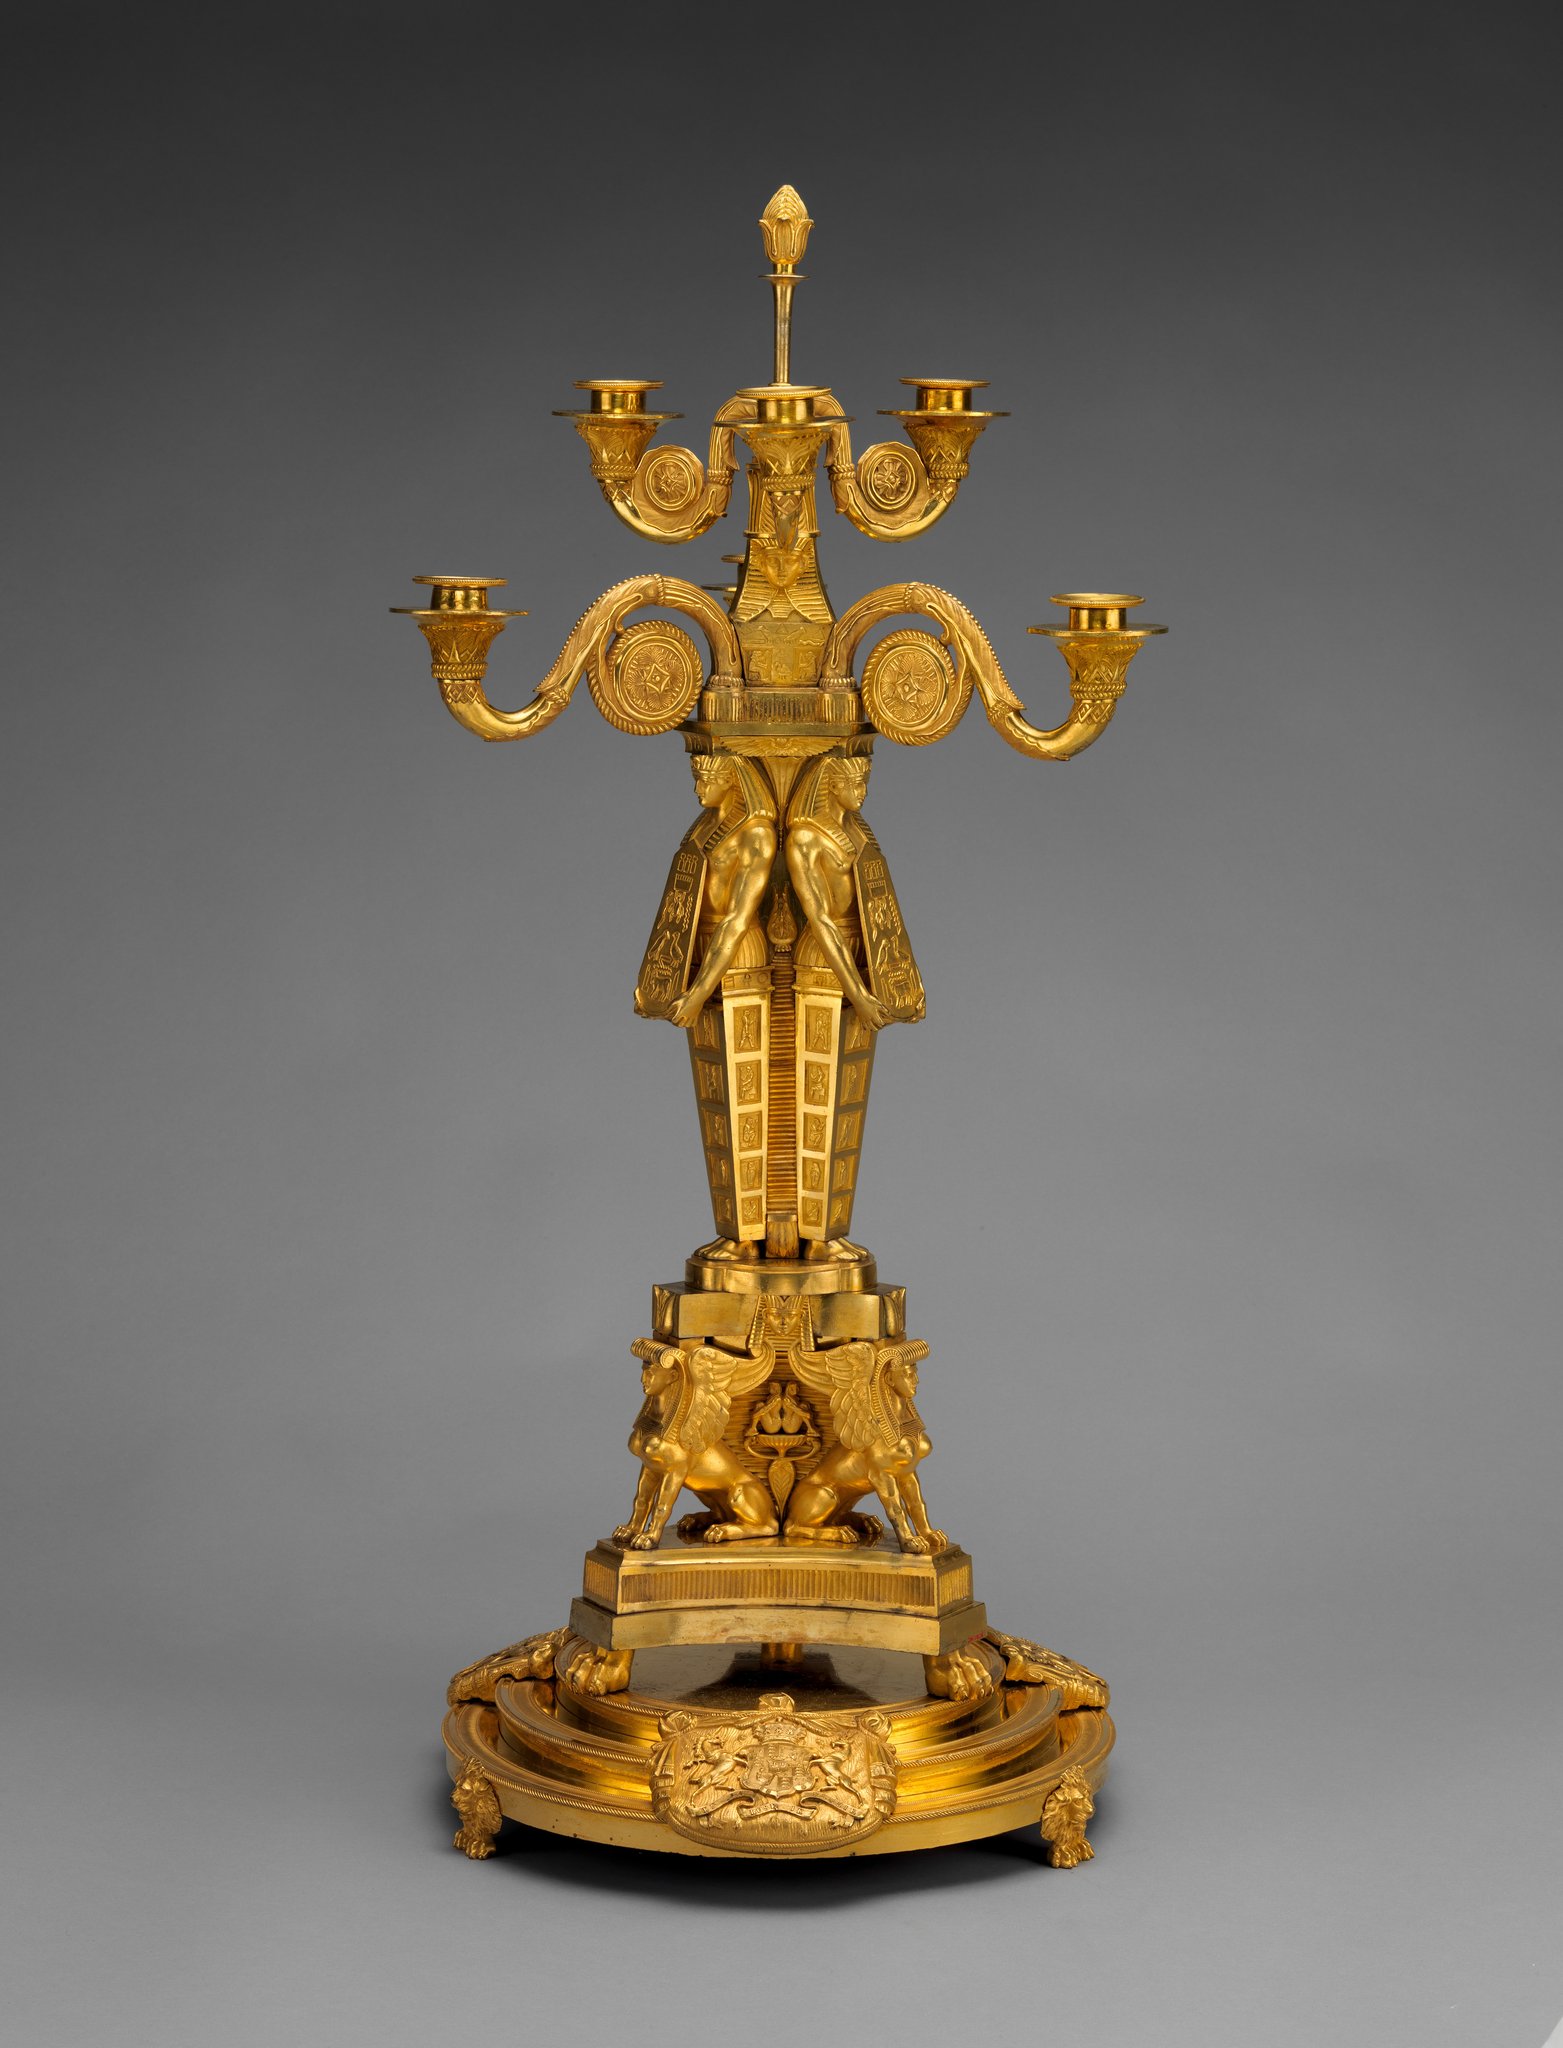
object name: candelabrum and stand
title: Egyptomania candelabrum (one of a pair)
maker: alexis decaix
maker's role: maker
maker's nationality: british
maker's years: 1778-1811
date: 1802-1806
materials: bronze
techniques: gilding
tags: hieroglyphs,sphinx